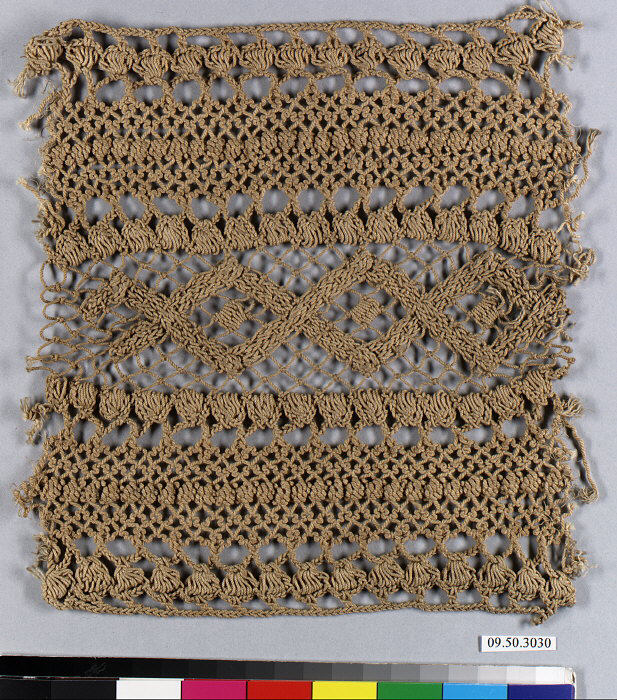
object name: sample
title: Crochet Work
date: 1801-1900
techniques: crochet